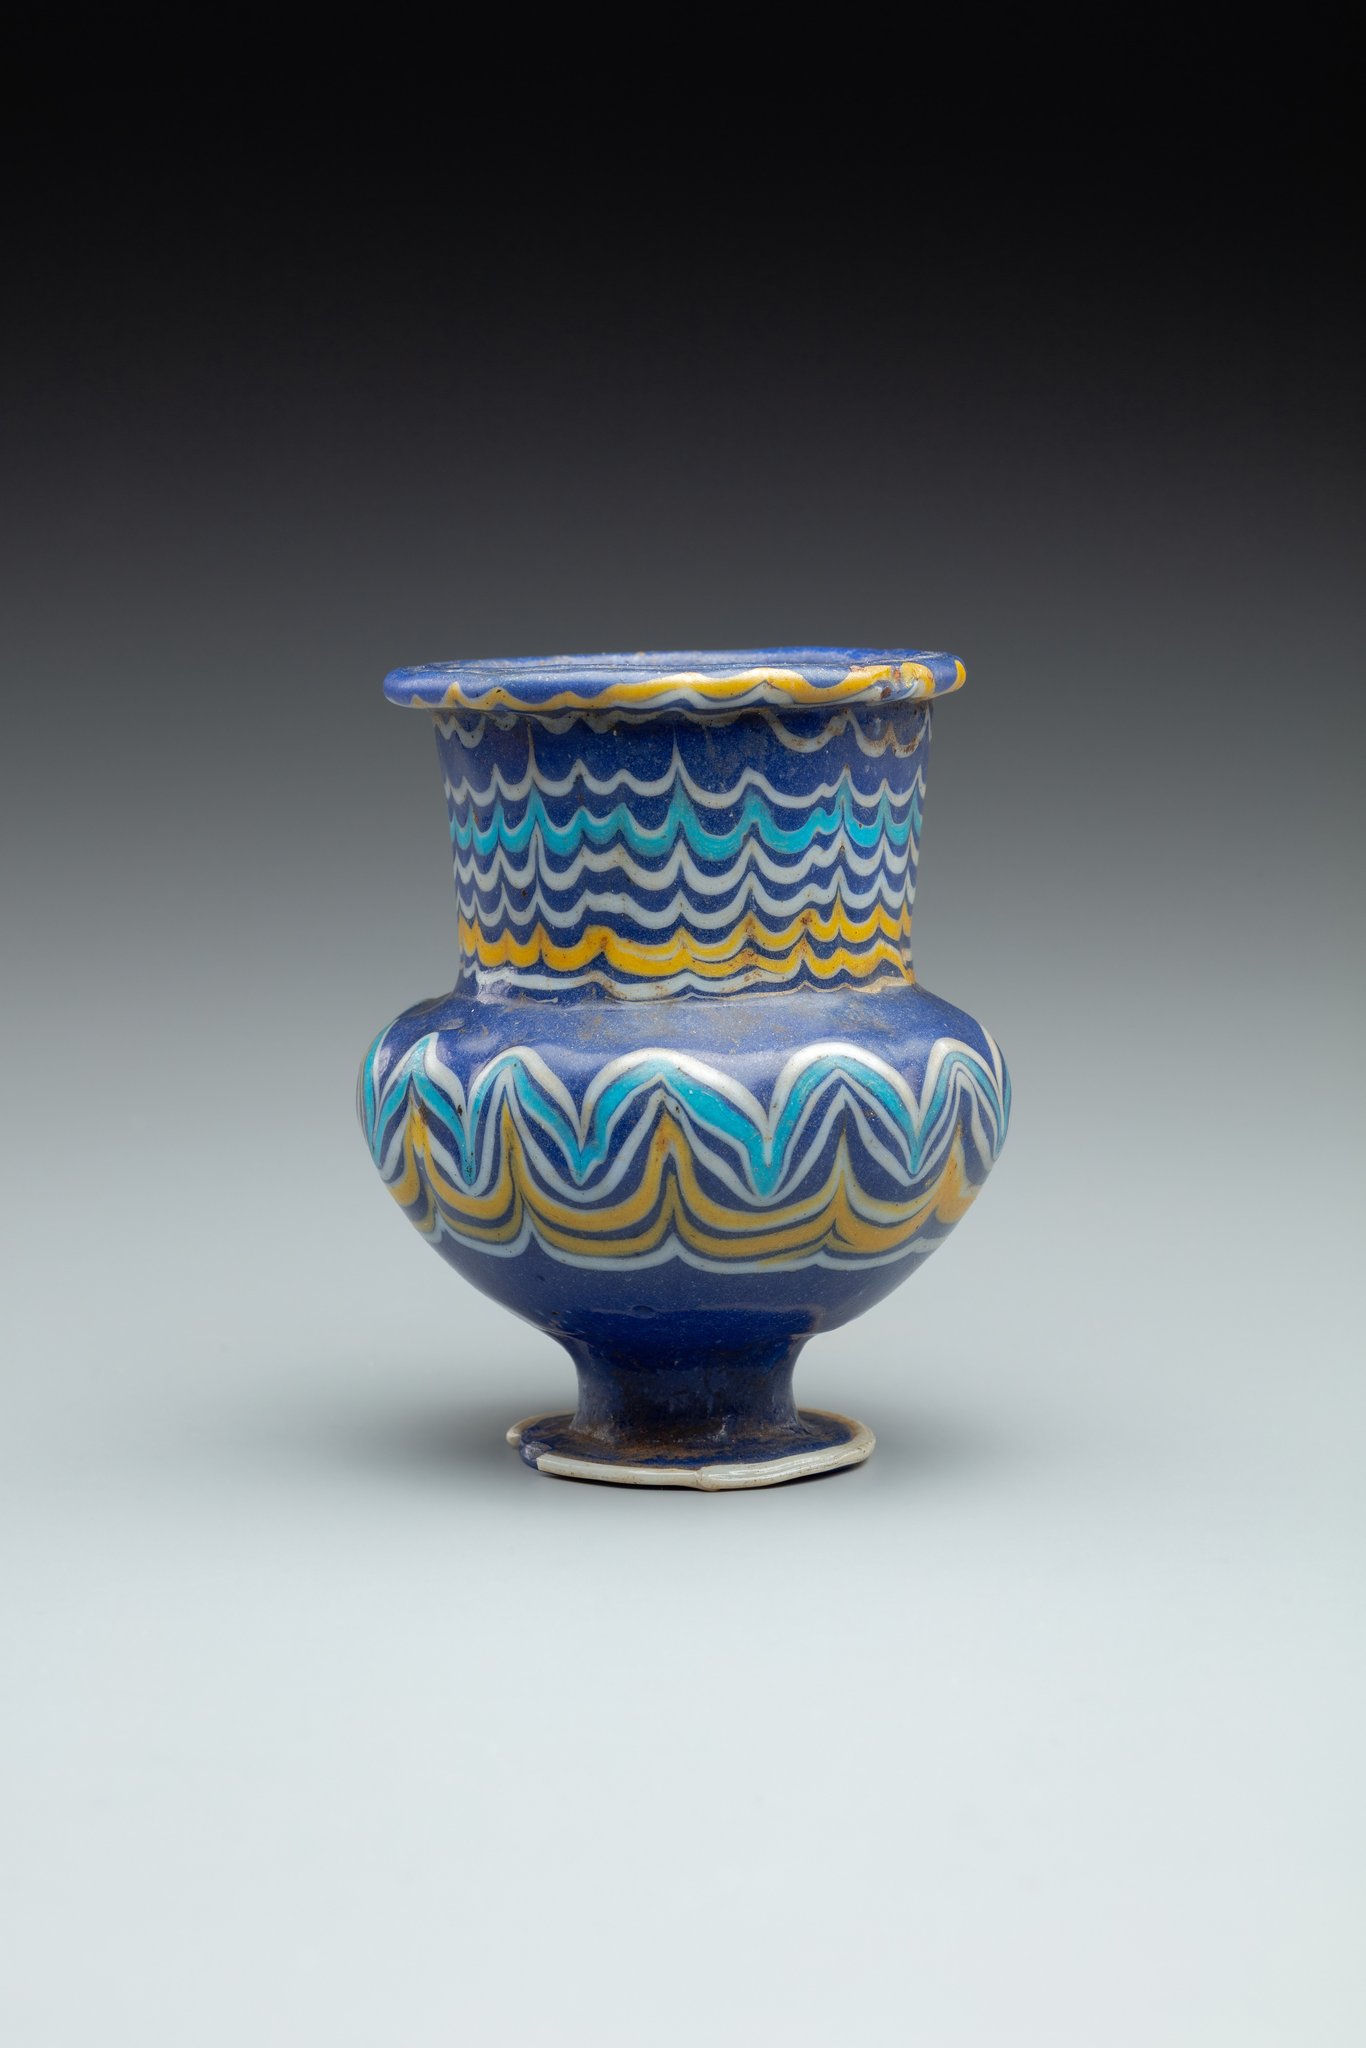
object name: vase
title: Glass krateriskos (unguent jar)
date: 1353-1323 BCE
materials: glass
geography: egypt